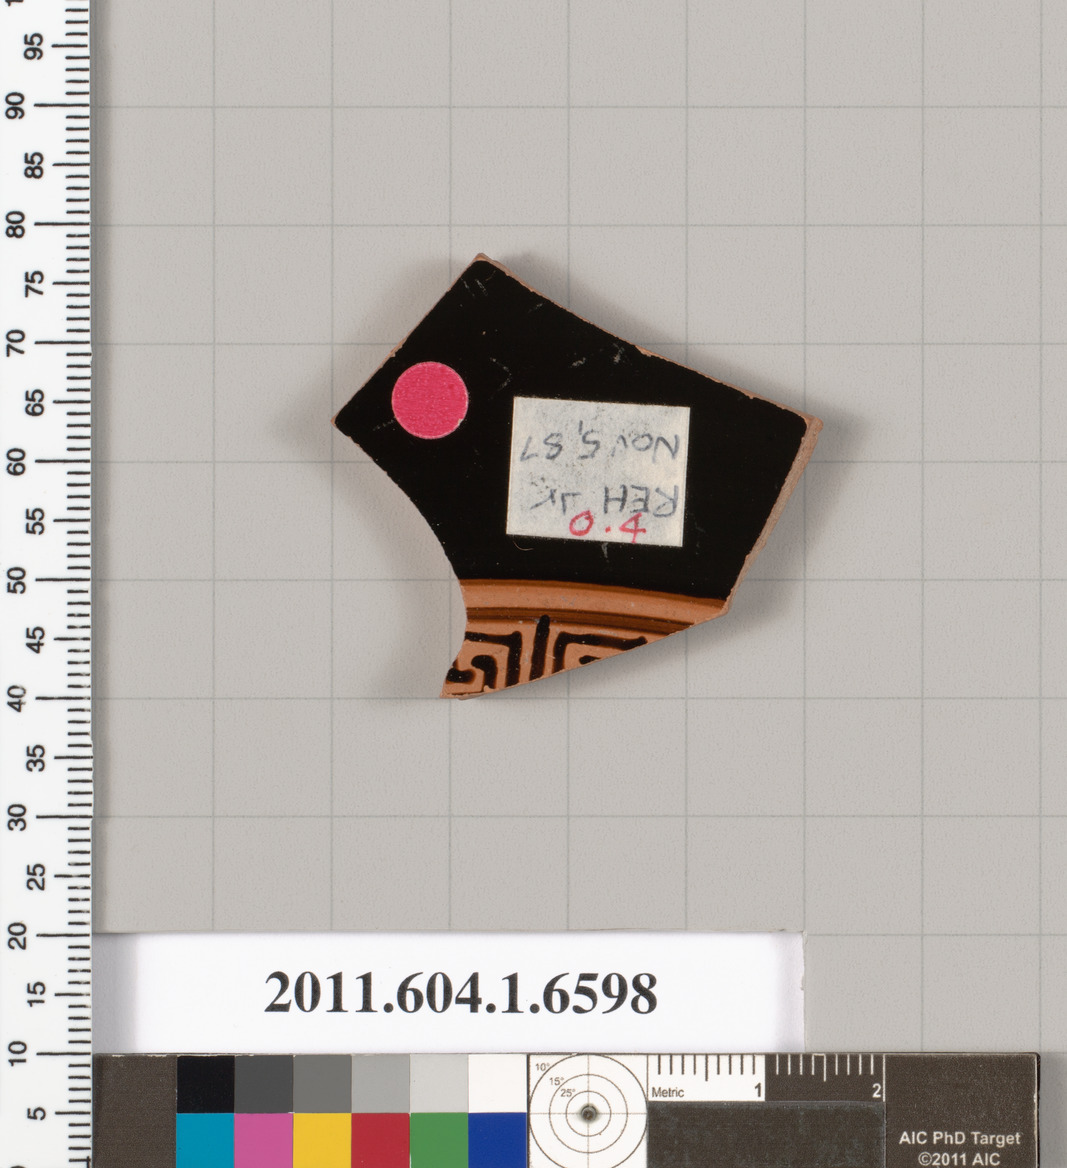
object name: kylix fragment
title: Terracotta fragment of a kylix (drinking cup)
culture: greek, attic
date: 490-480 BCE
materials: terracotta